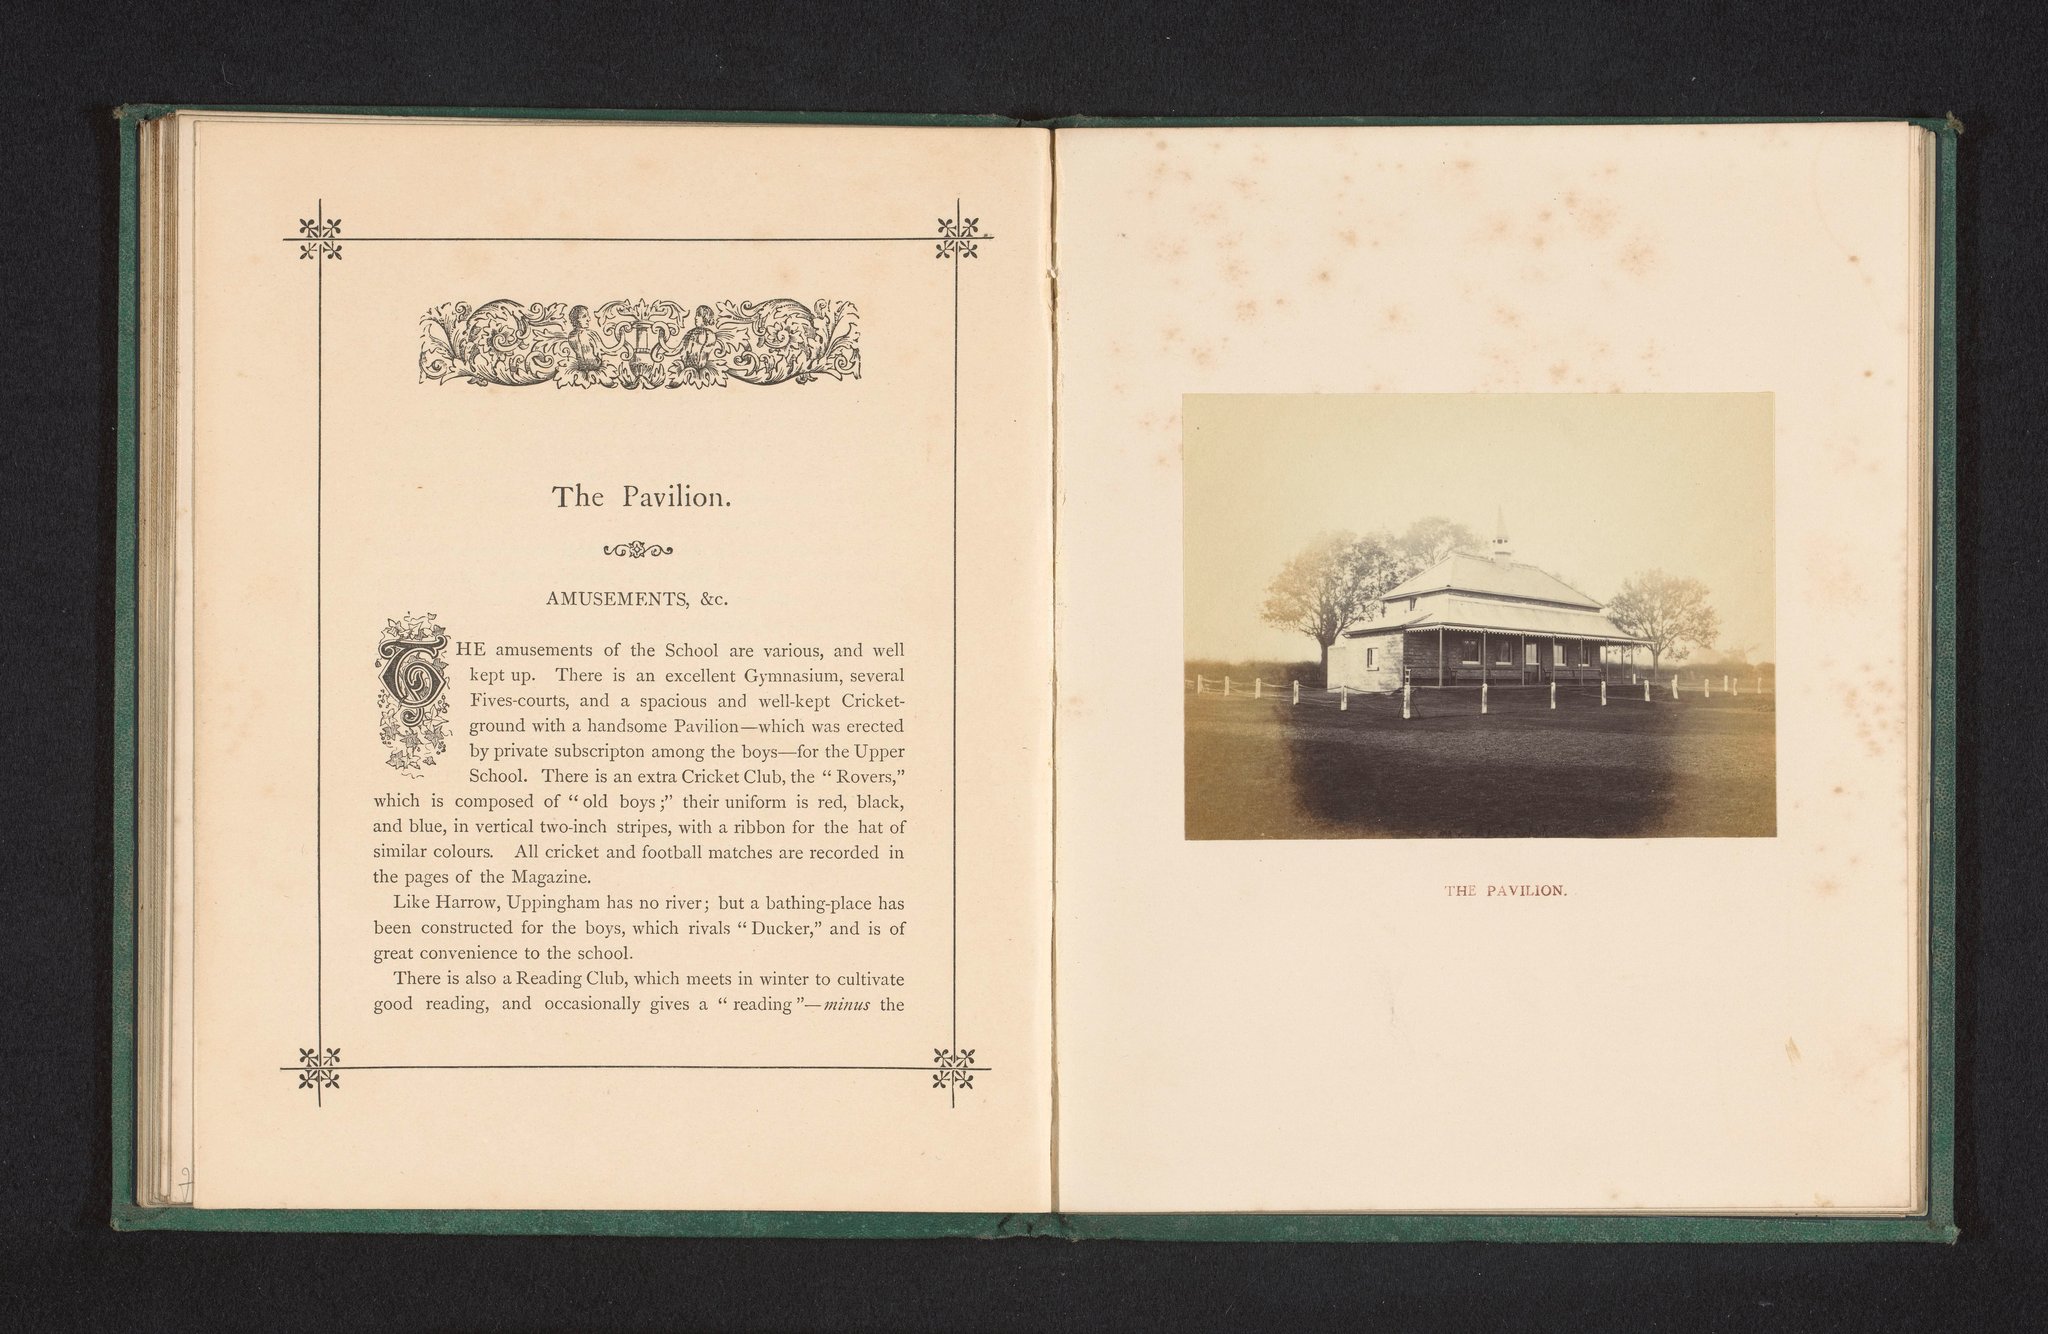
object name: page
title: Exterieur van het paviljoen van Uppingham School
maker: charles drake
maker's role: fotograaf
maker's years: 1846-1874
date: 1865-1870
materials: photographic support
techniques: albumen print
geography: uppingham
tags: façade (of house or building), elementary school; class, form